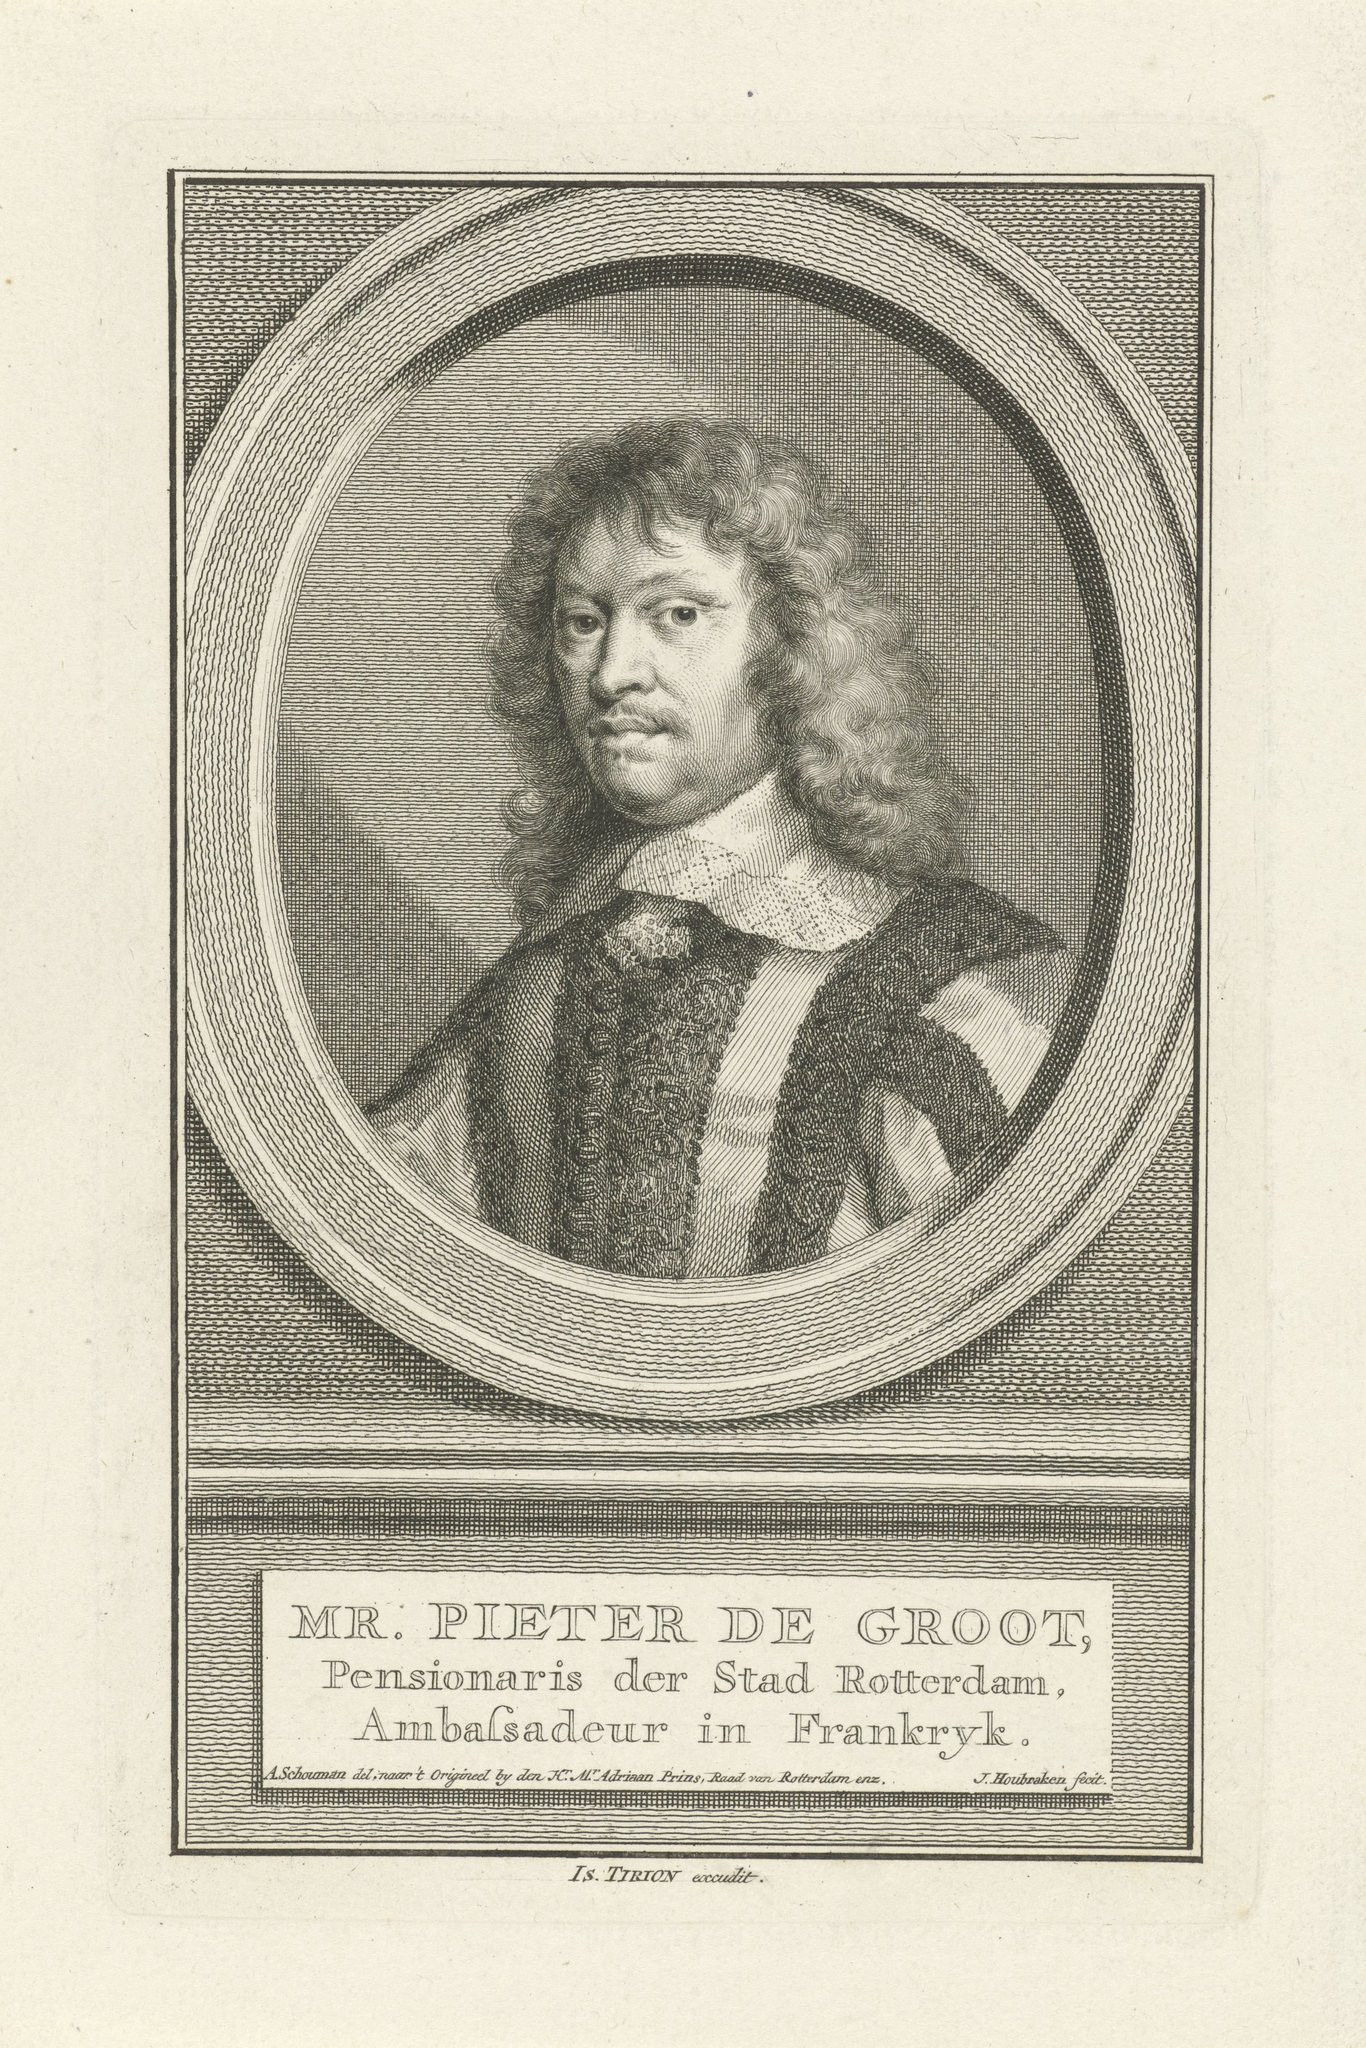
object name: print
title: Portret van Pieter de Groot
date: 1756-1770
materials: paper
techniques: engraving, etching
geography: amsterdam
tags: rotterdam, historical persons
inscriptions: collector's mark: Lugt 2228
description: Deze (voor zover bekend eerste) staat van prent ook gebruikt in: Wagenaar, Jan. Vaderlandsche historie, vervattende de geschiedenissen der Vereenigde Nederlanden (…). 21 delen. Amsterdam: Isaak Tirion, 1749-1759, dl. 14 (1756), p. 382. En in: Wagenaar, Jan. Vaderlandsche historie, vervattende de geschiedenissen der nu Vereenigde Nederlanden (…). 21 delen. Amsterdam: weduwe Isaak Tirion, 1770, dl. 14, p. 382. Latere (voor zover bekend tweede) staat van prent ook gebruikt in: Wagenaar, Jan. Vaderlandsche historie, vervattende de geschiedenissen der nu Vereenigde Nederlanden (…). 21 delen. Amsterdam, Leiden, Dordrecht en Harlingen: P. Schouten e.a., 1782, dl. 14, p. 382. En in: Wagenaar, Jan. Vaderlandsche historie, vervattende de geschiedenissen der nu Vereenigde Nederlanden (…). 21 delen. Amsterdam: Johannes Allart, 1790-1796; dl. 14 (1794), p. 382.